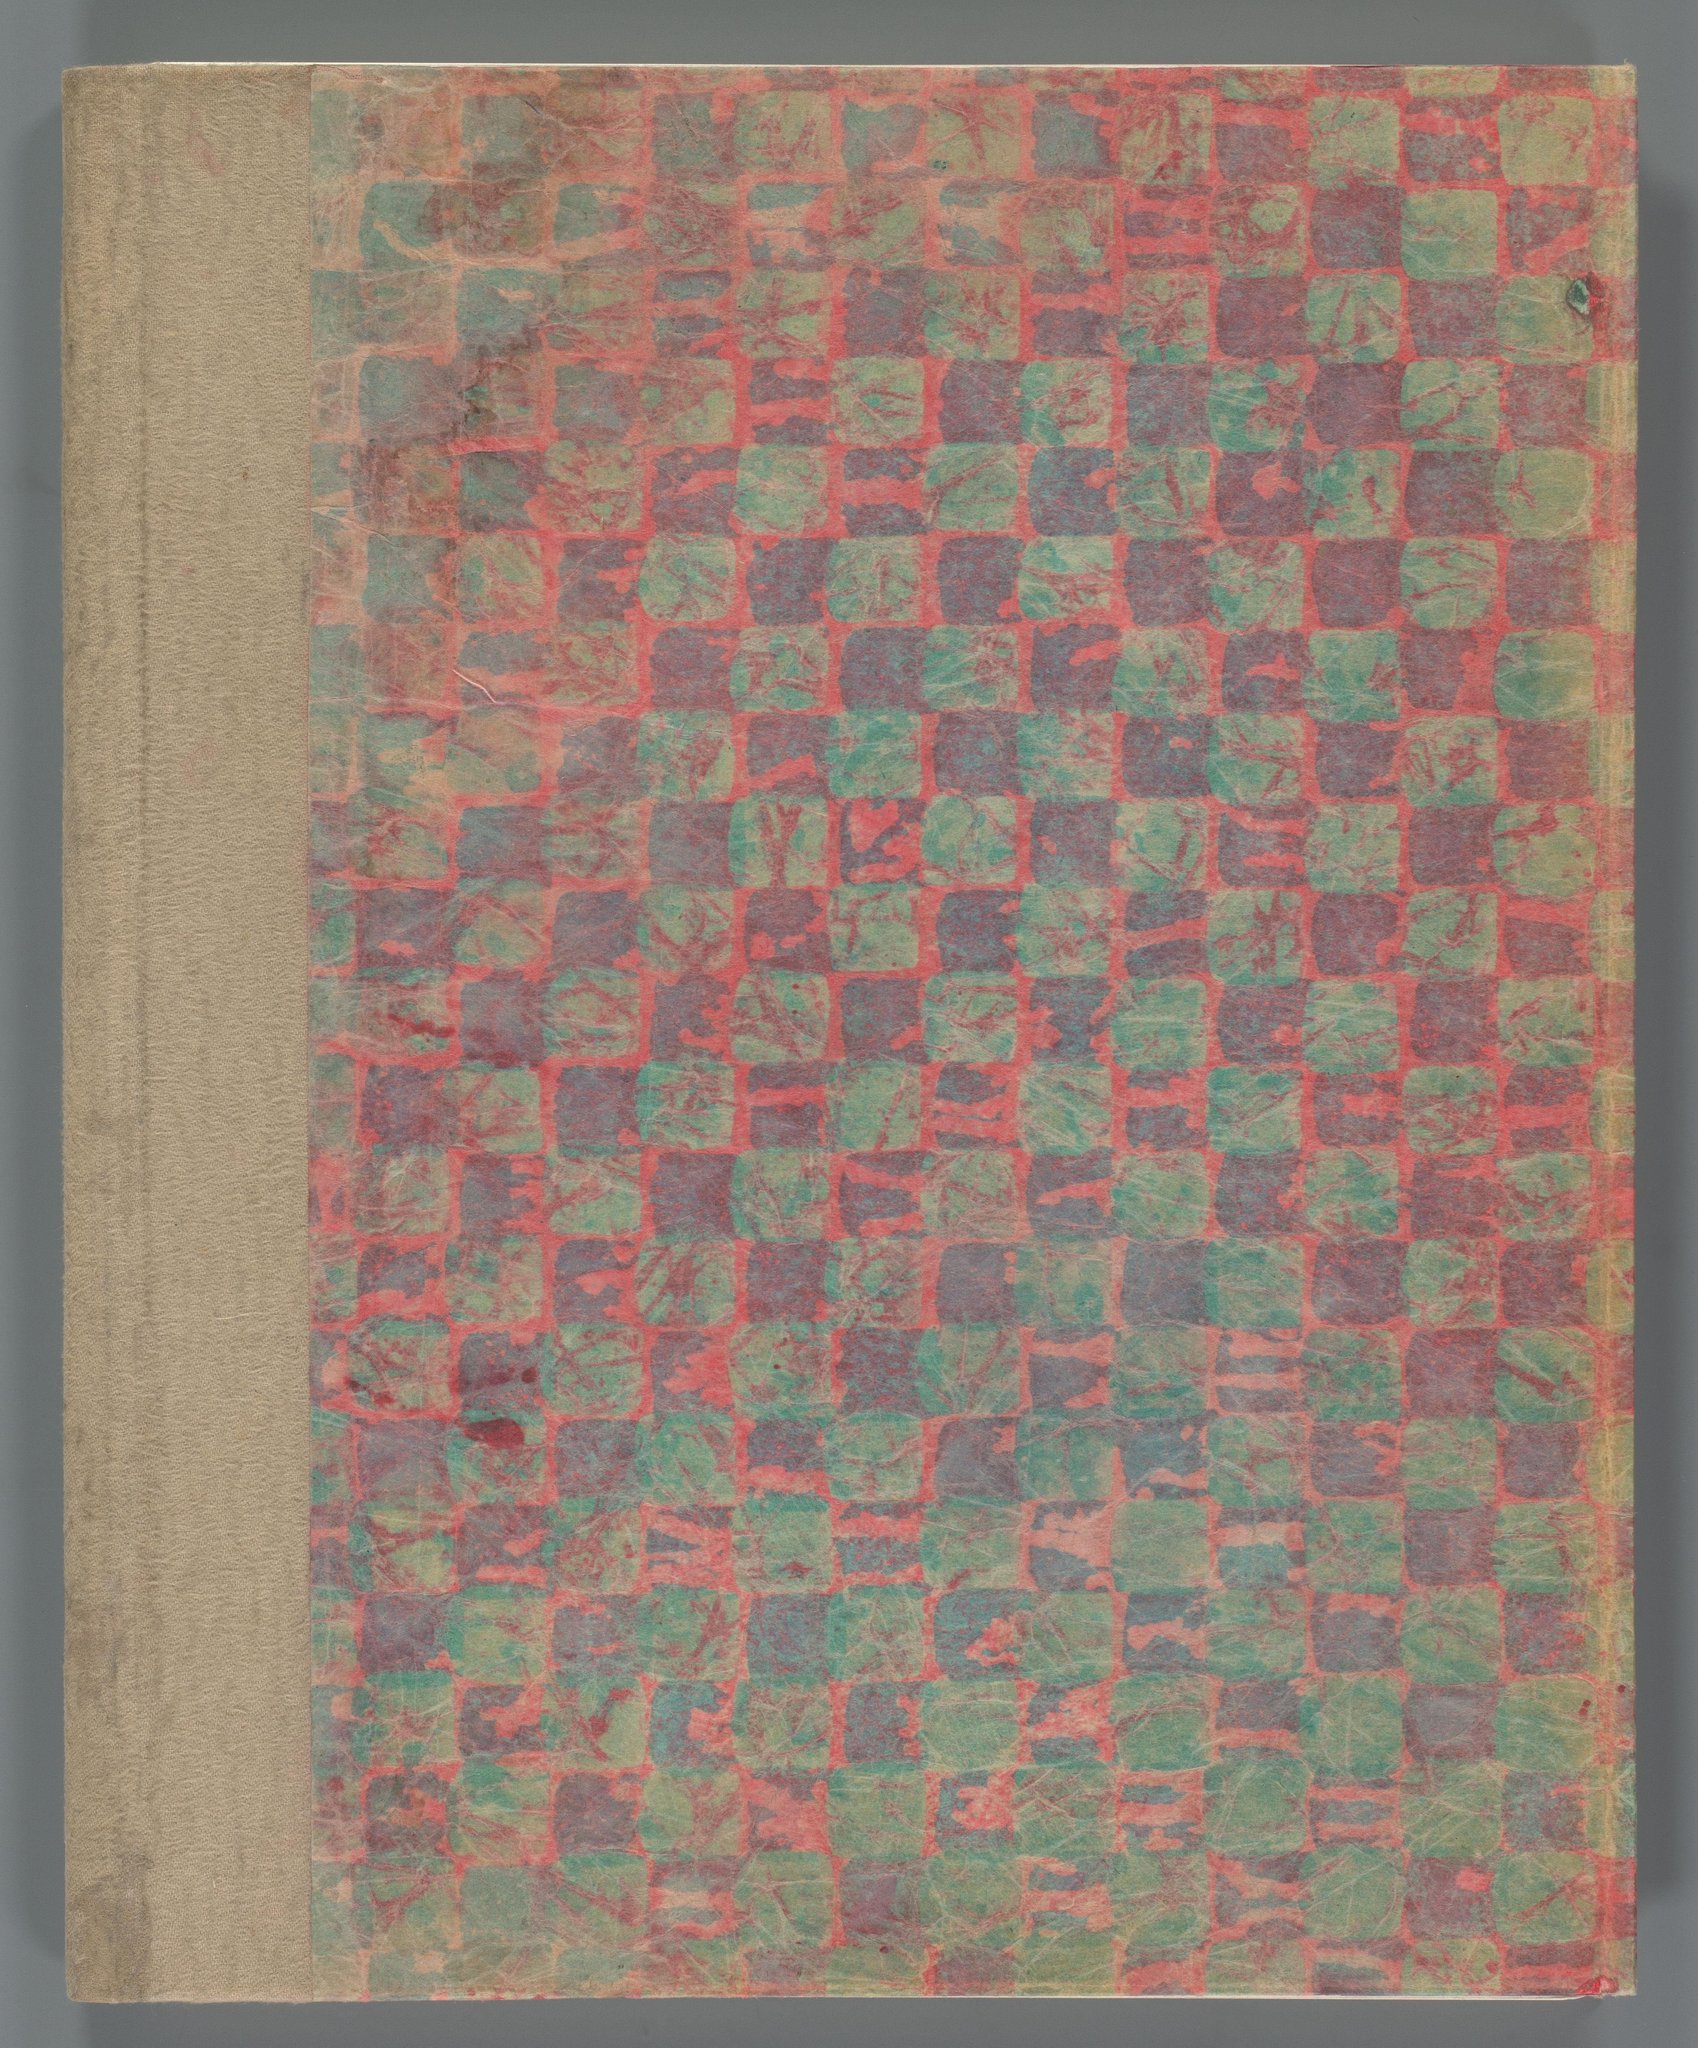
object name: wrapper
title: Omslag met twintig prenten waarvan zestien proefdrukken zijn voor dezelfde illustratie voor een (onbekend) werk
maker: bernard willem wierink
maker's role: draughtsman, print maker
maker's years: 1856-1939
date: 1866-1939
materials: cardboard, paper, linen, paint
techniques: bookbinding, printing block, relief print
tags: print, e.g.: engraving, etching, lithograph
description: Map van roze en groen geblokt sierpapier en rug van linnen.